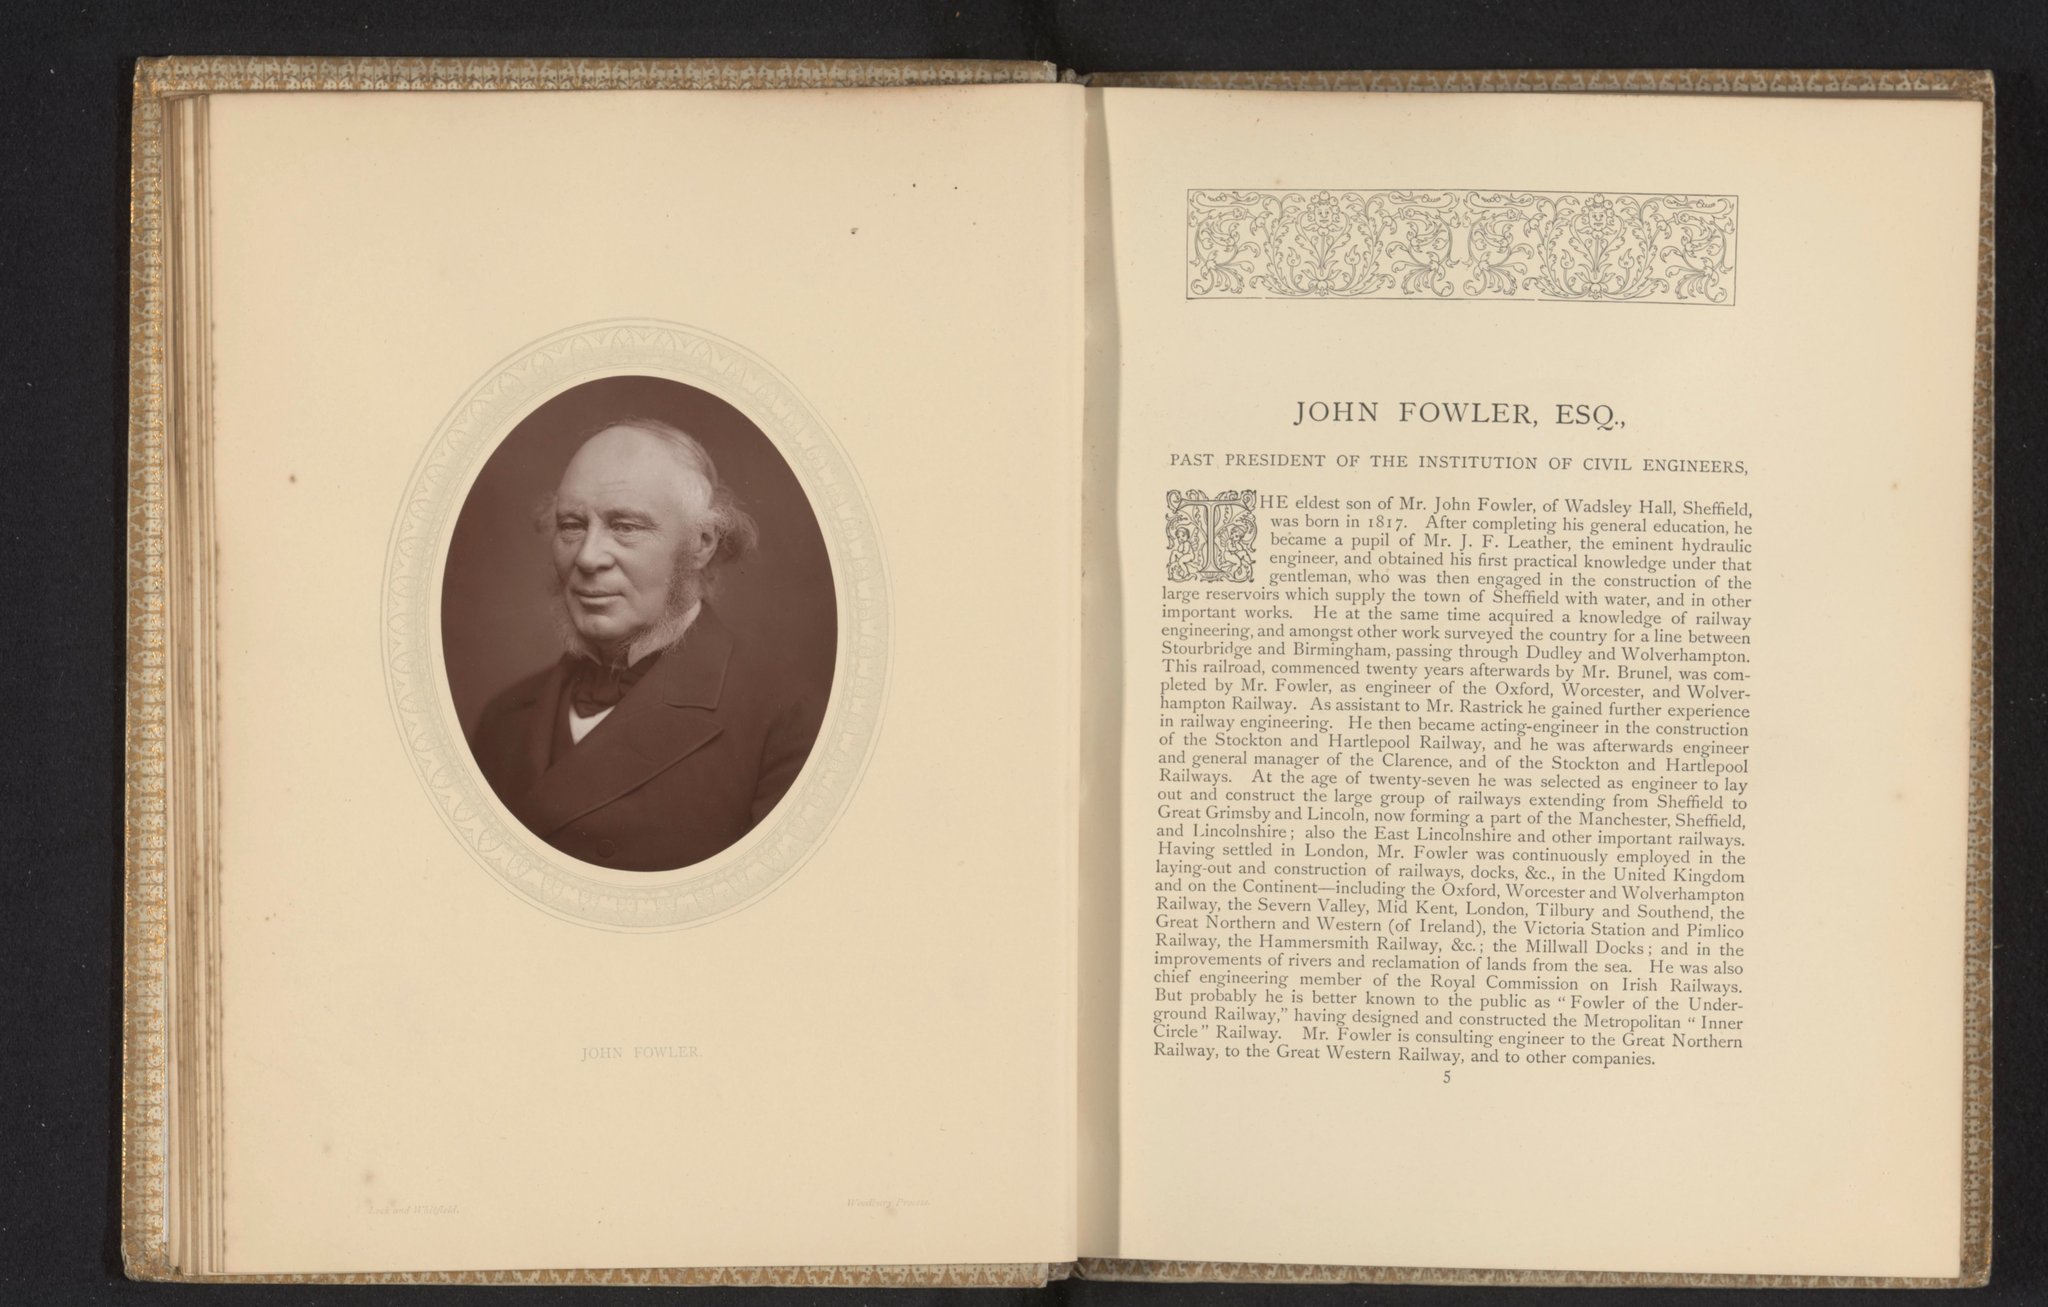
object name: page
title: John Fowler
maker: Anonymous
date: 1877-1882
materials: paper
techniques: woodburytype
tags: engineer, engineering, historical persons (portraits and scenes from the life) (+ (full) bust portrait)